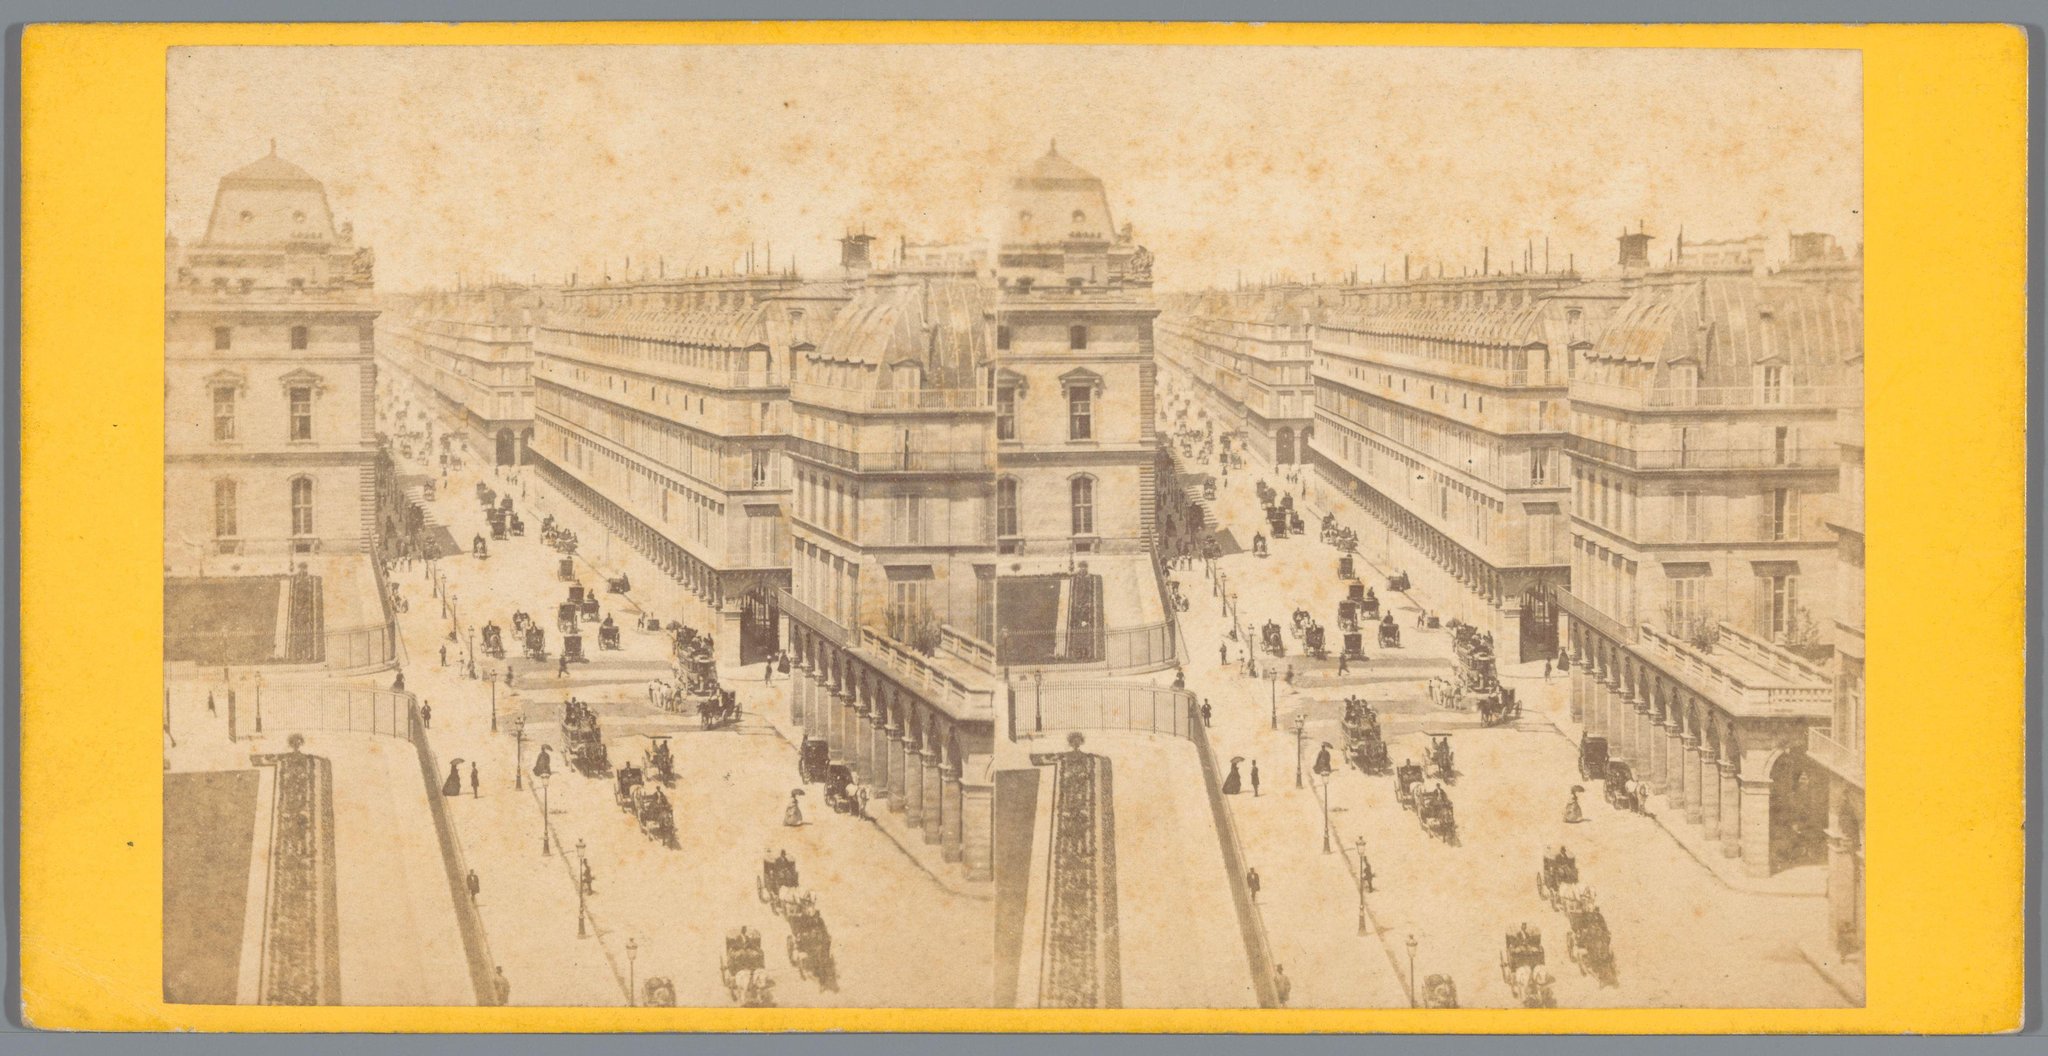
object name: stereograph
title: Gezicht op de Rue de Rivoli met een deel van het Palais du Louvre in Parijs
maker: Anonymous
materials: cardboard, photographic support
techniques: albumen print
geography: paris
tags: animal traction, animal-drawn vehicle (carriage etc.), street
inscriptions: inscription: ‘Rue de Rivoli Aug-Sept. 68 L.H. Kuhn’